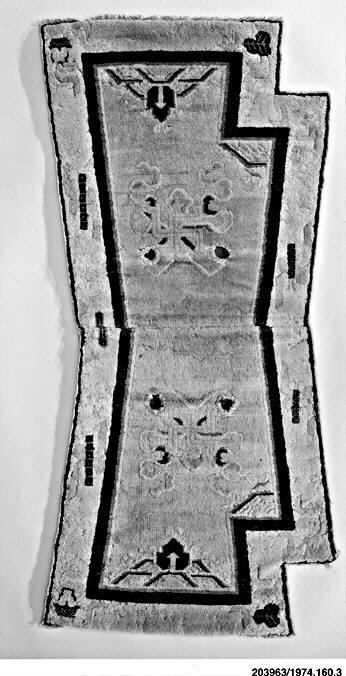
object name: rug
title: Saddle Rug with Swastikas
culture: chinese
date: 1701-1800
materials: cotton, wool